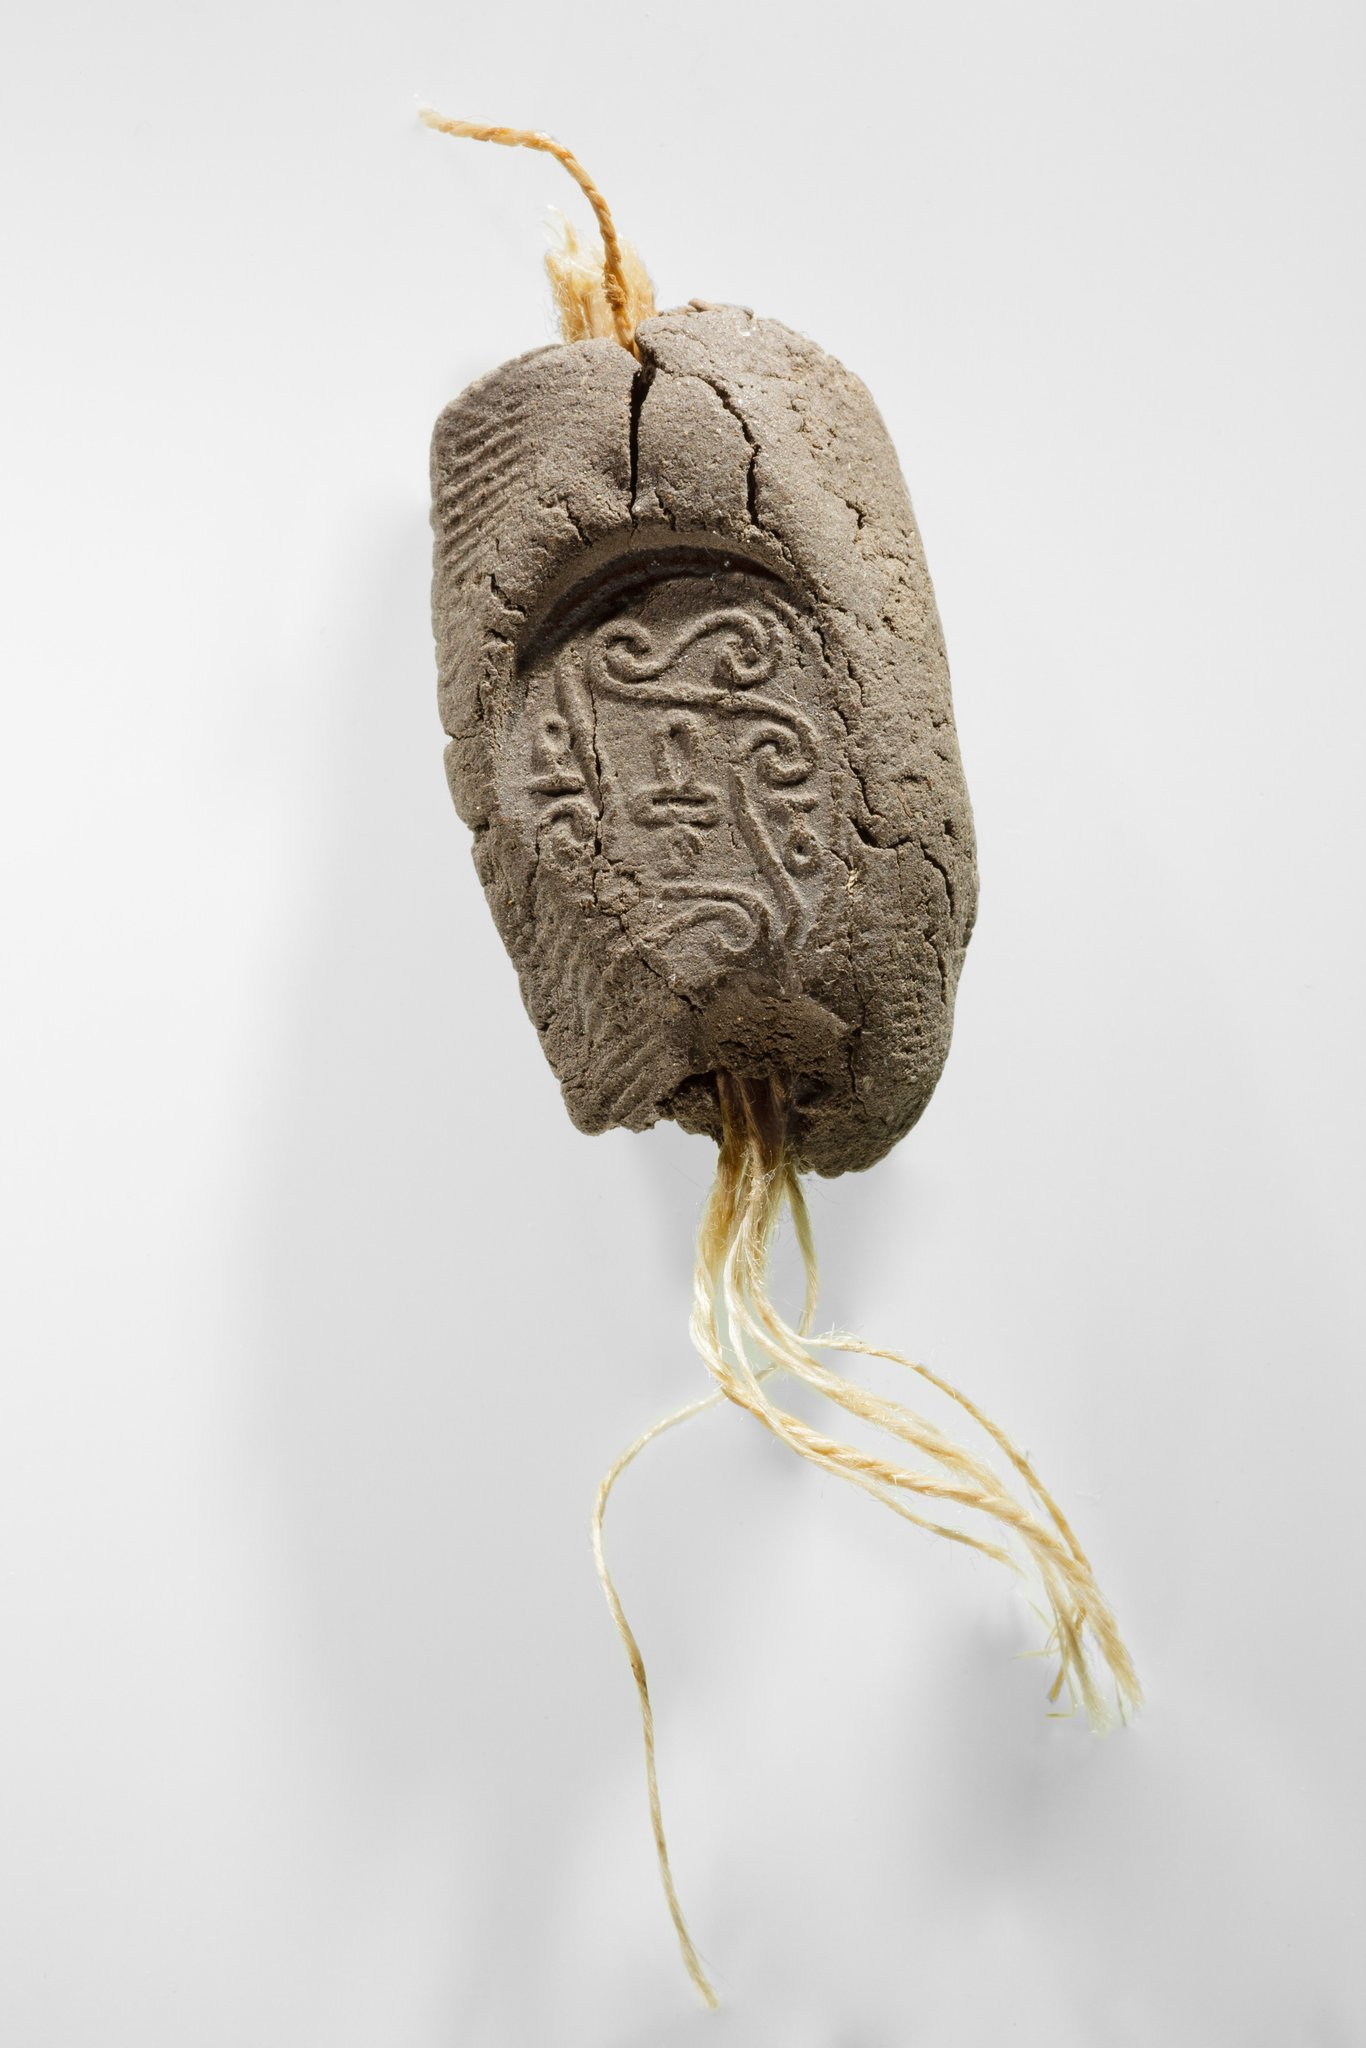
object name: sealing, from heqanakht papyrus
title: Sealing with Scarab Impressions from Heqanakht's Letters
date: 1956-1953 BCE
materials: mud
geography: egypt